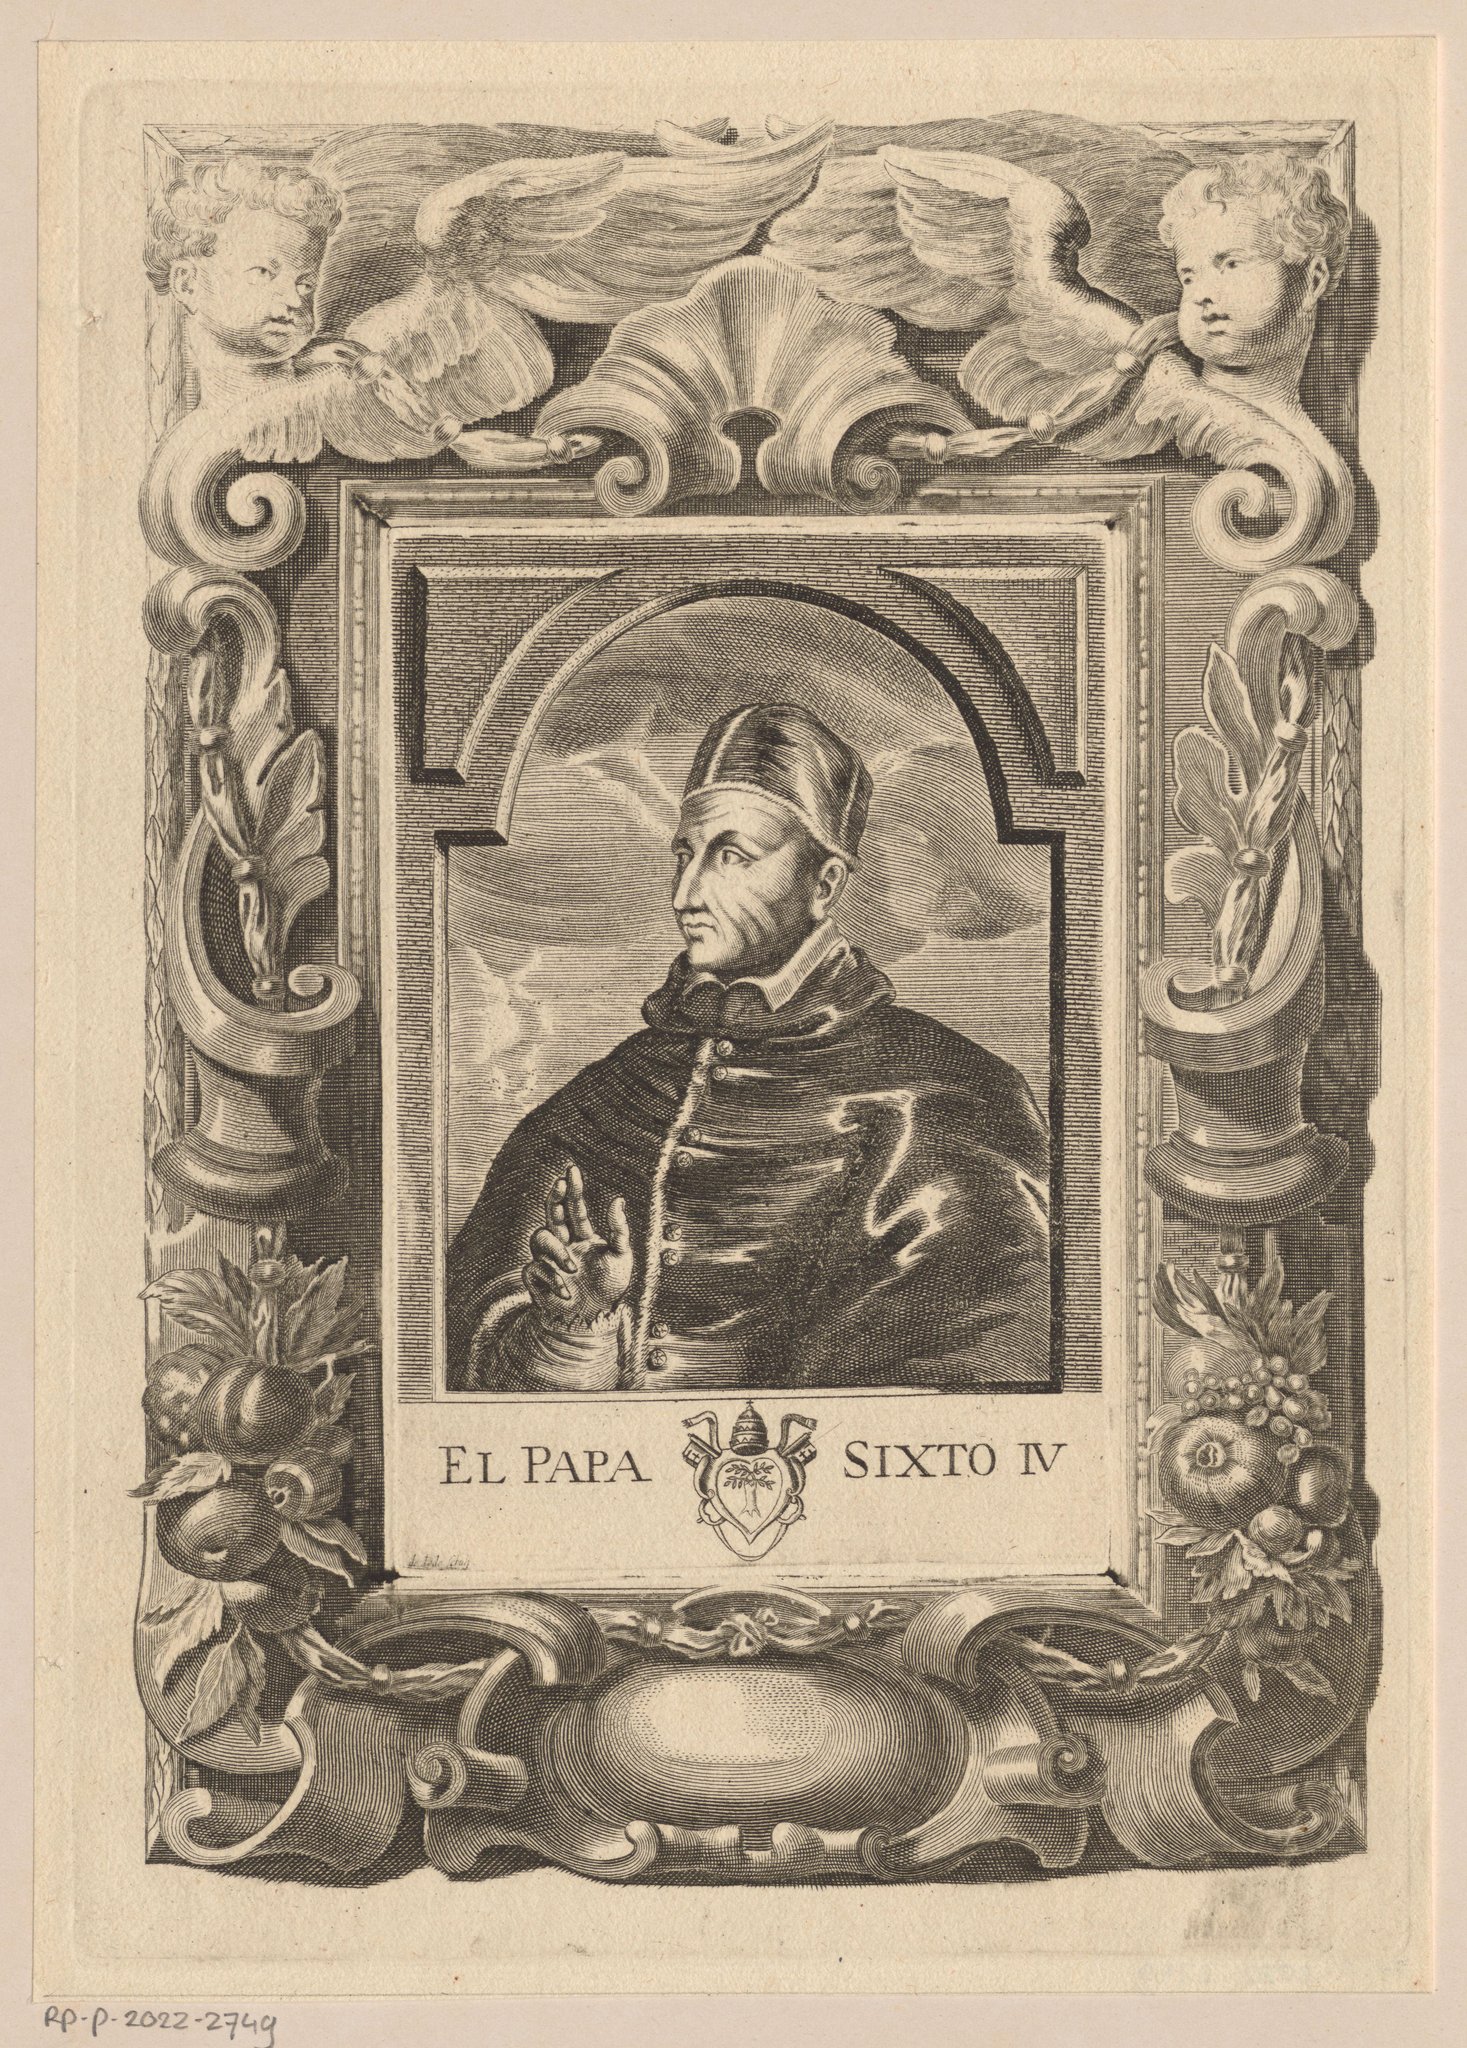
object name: print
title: Portret van Sixtus IV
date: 1616-1674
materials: paper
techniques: engraving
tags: historical persons, pope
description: Met eenregelig onderschrift in het Frans.